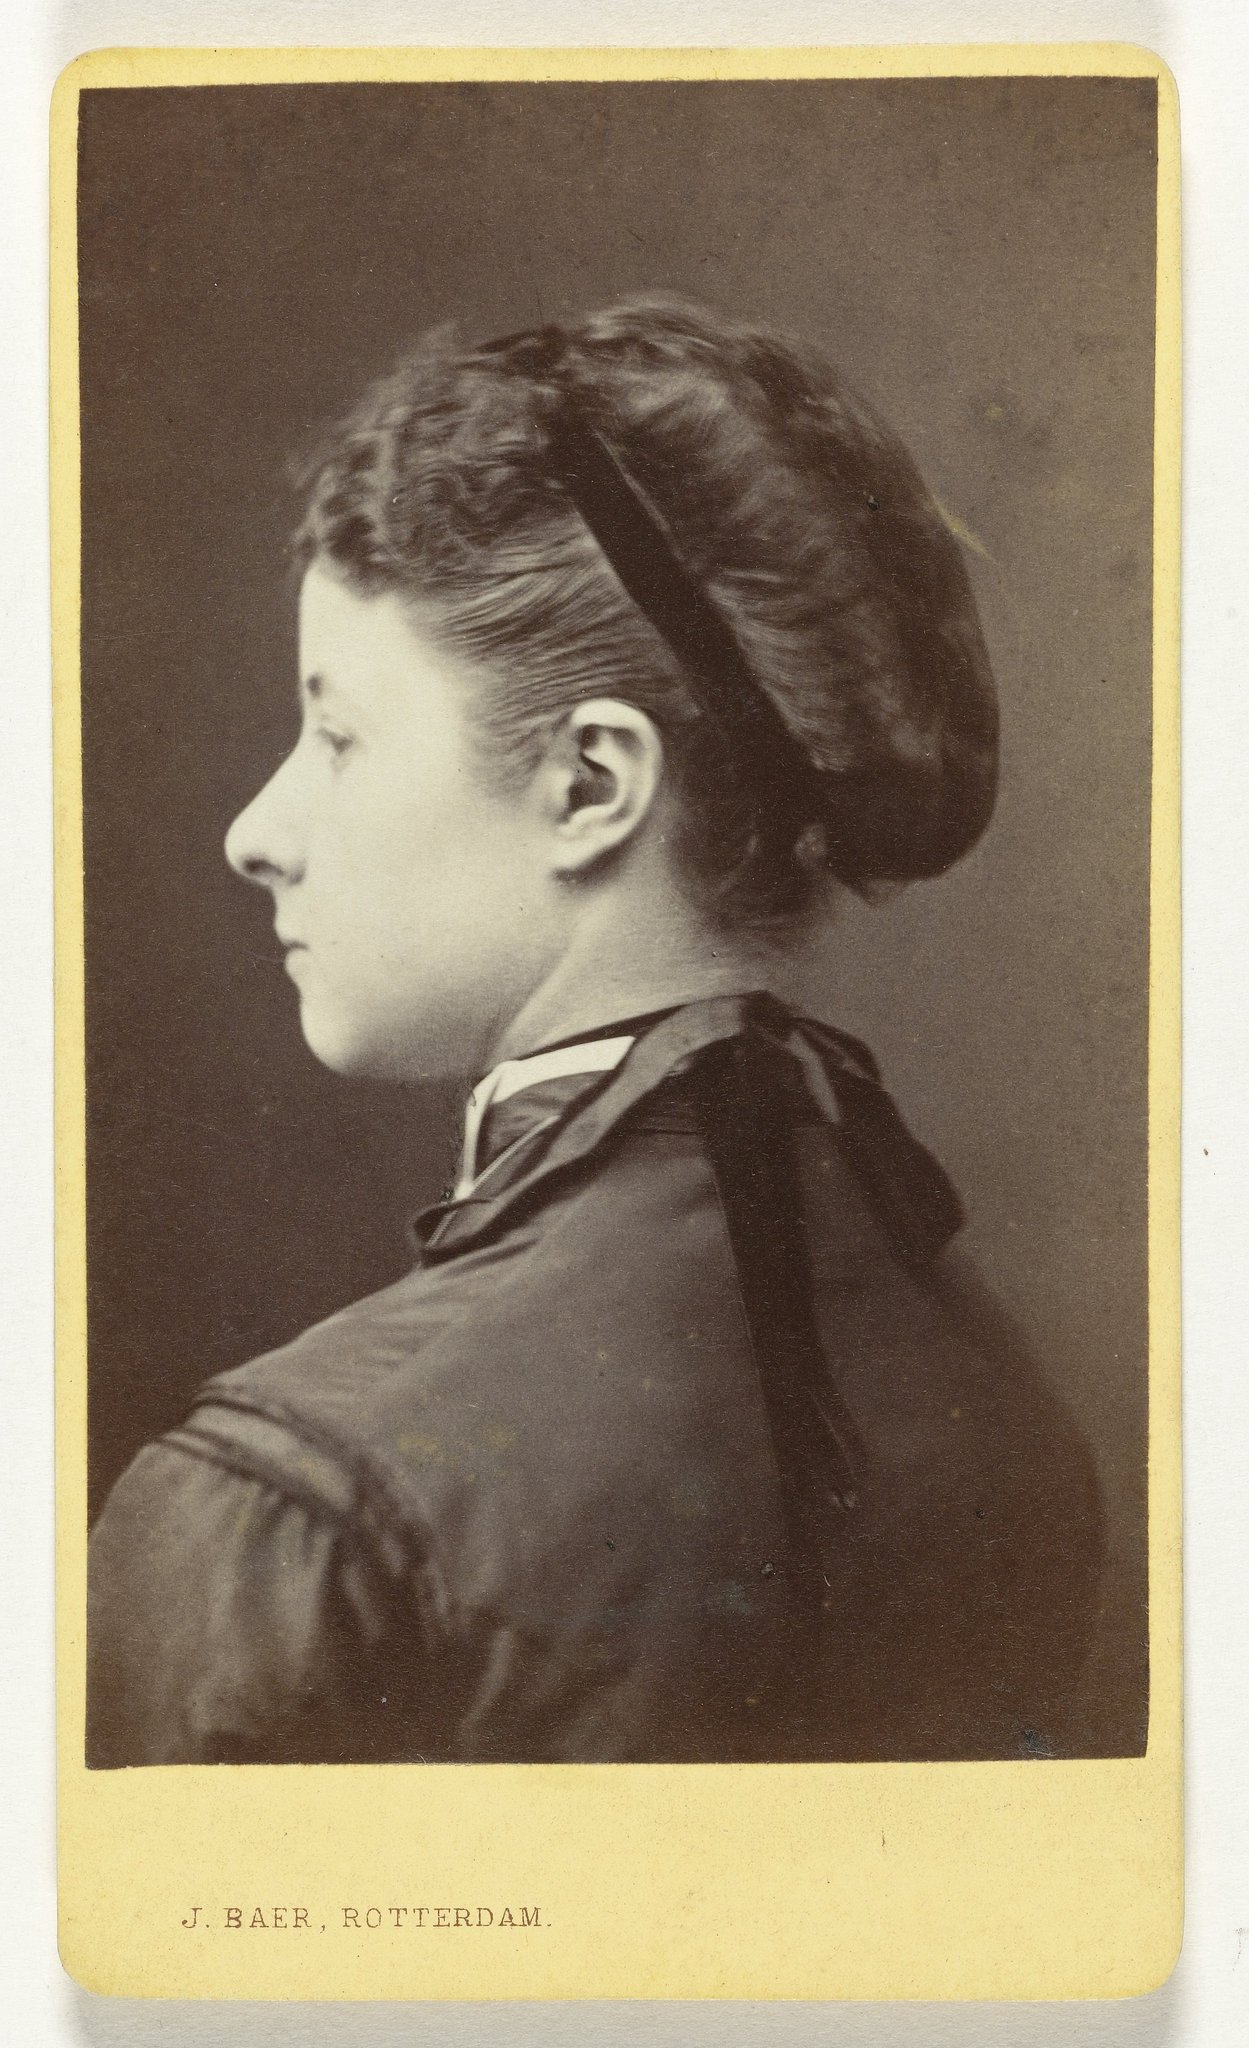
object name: carte de visite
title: Cartes-de-visite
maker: johannes baer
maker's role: fotograaf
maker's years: 1840-1912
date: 1865-1870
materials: cardboard, paper, photographic support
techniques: albumen print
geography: rotterdam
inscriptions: address: ‘J. Baer/Photographe/Rotterdam’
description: Cartomanie was a collecting craze. From 1855 hundreds of thousands of these portraits were annually sold worldwide. People had photographs taken of their loved ones, including their pets, and kept them in an album. Portraits of kings, writers, artists, actors, and statesmen were also collected. Photography was no longer the preserve of the wealthy; farmers and maidservants now also stood before the camera.